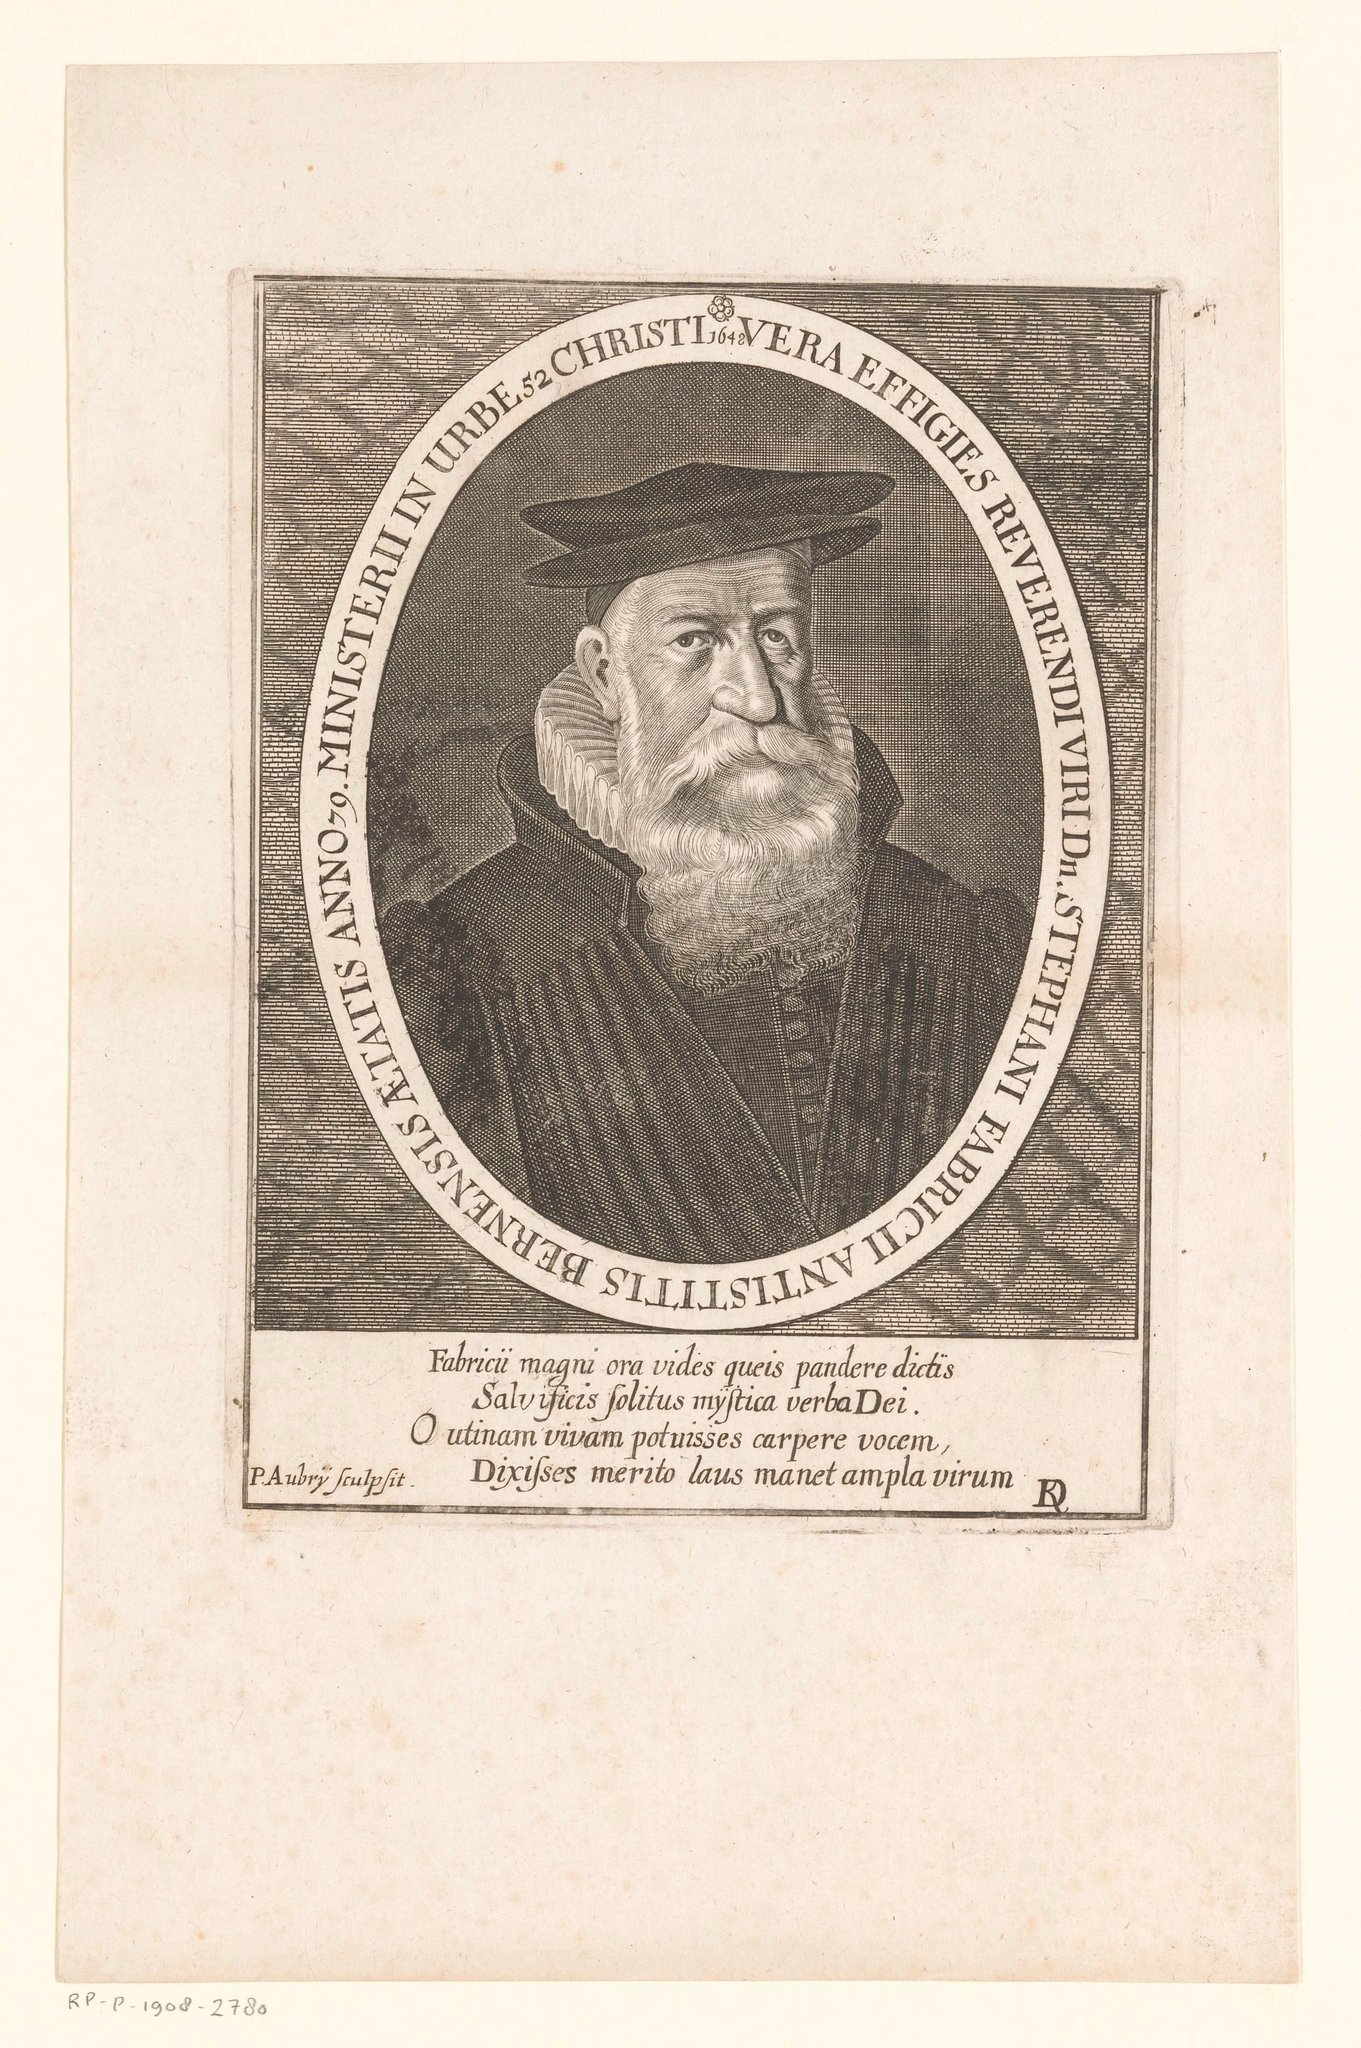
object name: print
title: Portret van Stephan Fabricius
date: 1656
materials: paper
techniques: engraving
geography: straatsburg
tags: historical persons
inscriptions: collector's mark: Lugt 2228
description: Prent ook gebruikt in: [Fabricius, Stephan]. Conciones sacrae festivitatibus annuis habitae. Bern: Georg Sonnleitner, 1656.